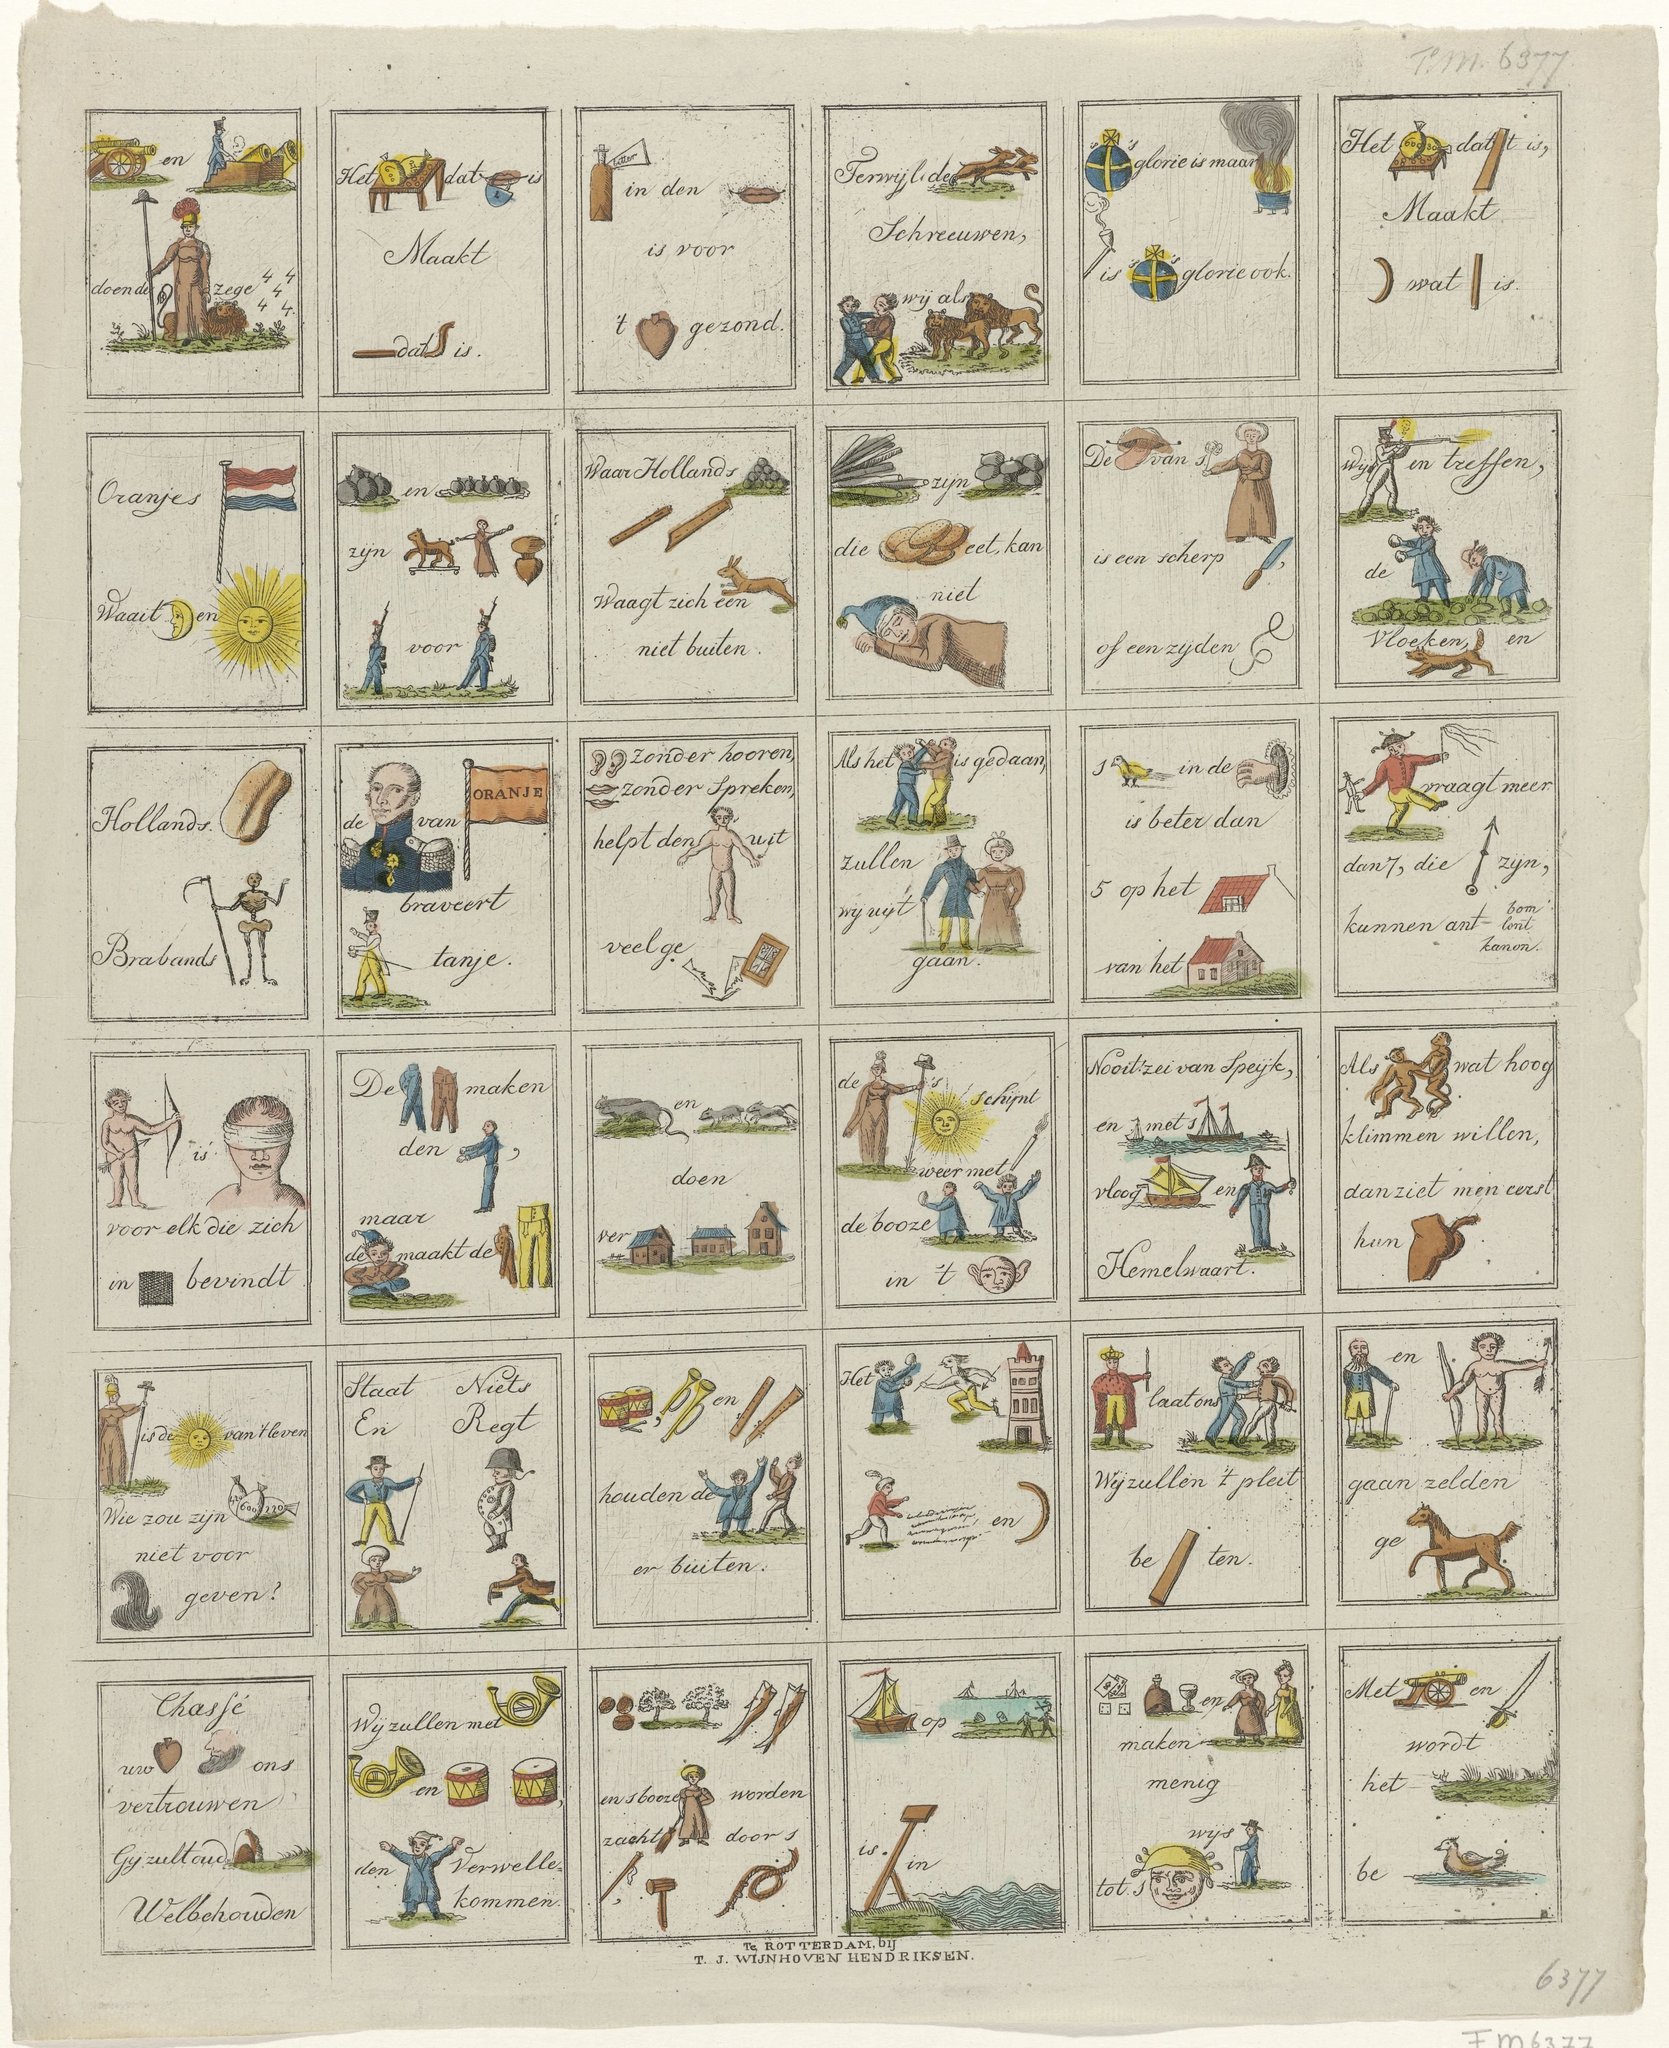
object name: print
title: Rebus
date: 1831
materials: paper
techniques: etching, hand coloring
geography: netherlands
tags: amsterdam, antwerp, jan van speyk, david hendrik baron chassé, berlin, william i of the netherlands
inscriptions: collector's mark: Lugt 2228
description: Blad met een rebus in 36 voorstellingen, ten tijde van de Belgische Revolutie in 1831. In de rebus komen voor: koning Willem I, Jan van Speyk en generaal Chassé. Ongenummerd.